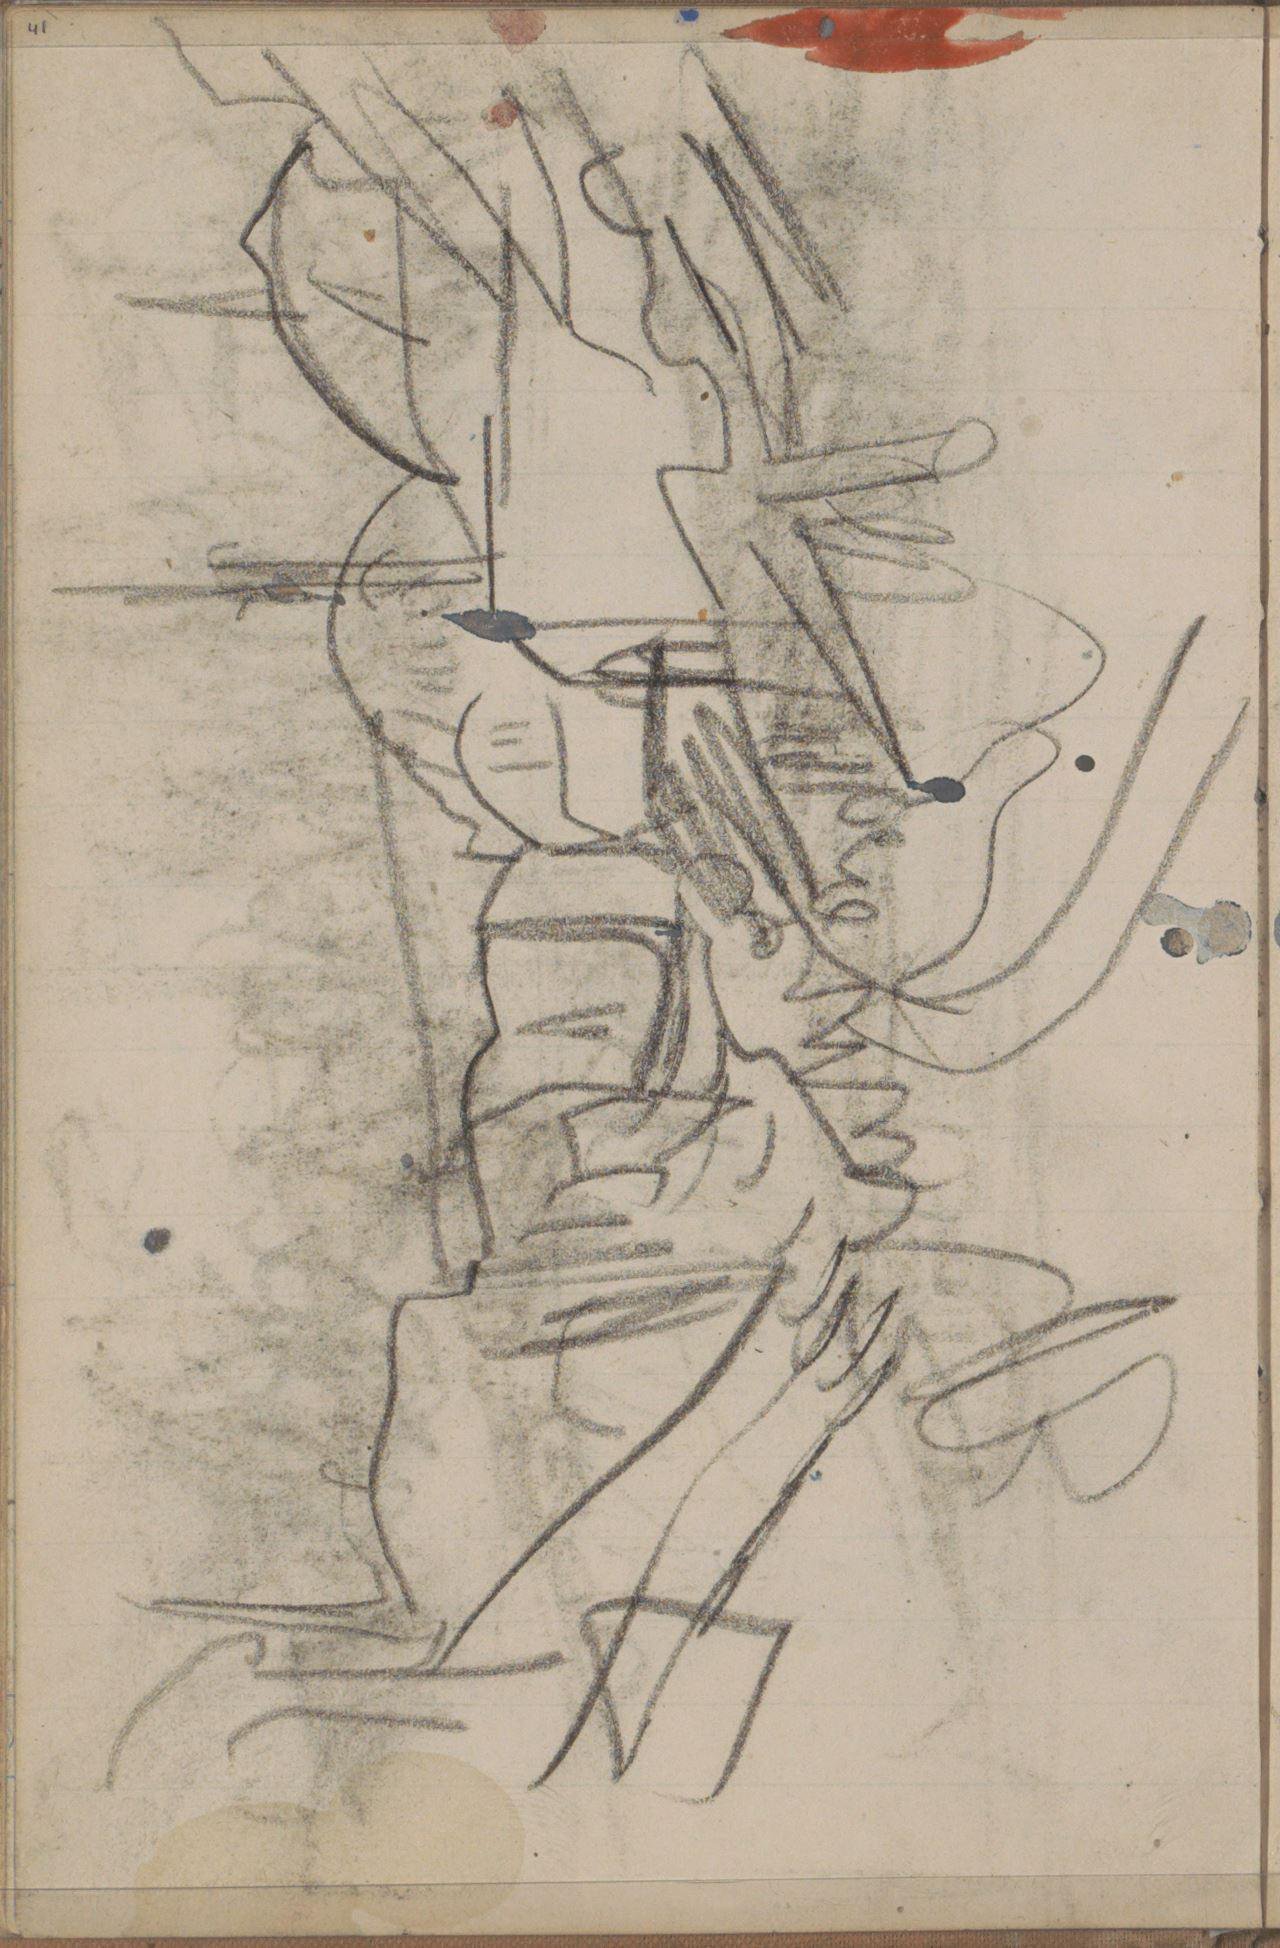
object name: sketchbook leaf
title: Studieblad met koepeldaken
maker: marius bauer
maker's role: draughtsman, print maker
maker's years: 1867-1932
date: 1888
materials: chalk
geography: istanbul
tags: dome ~ architecture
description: Mogelijk de daken van een moskee. Pagina 41 uit een schetsboek met 56 bladen.